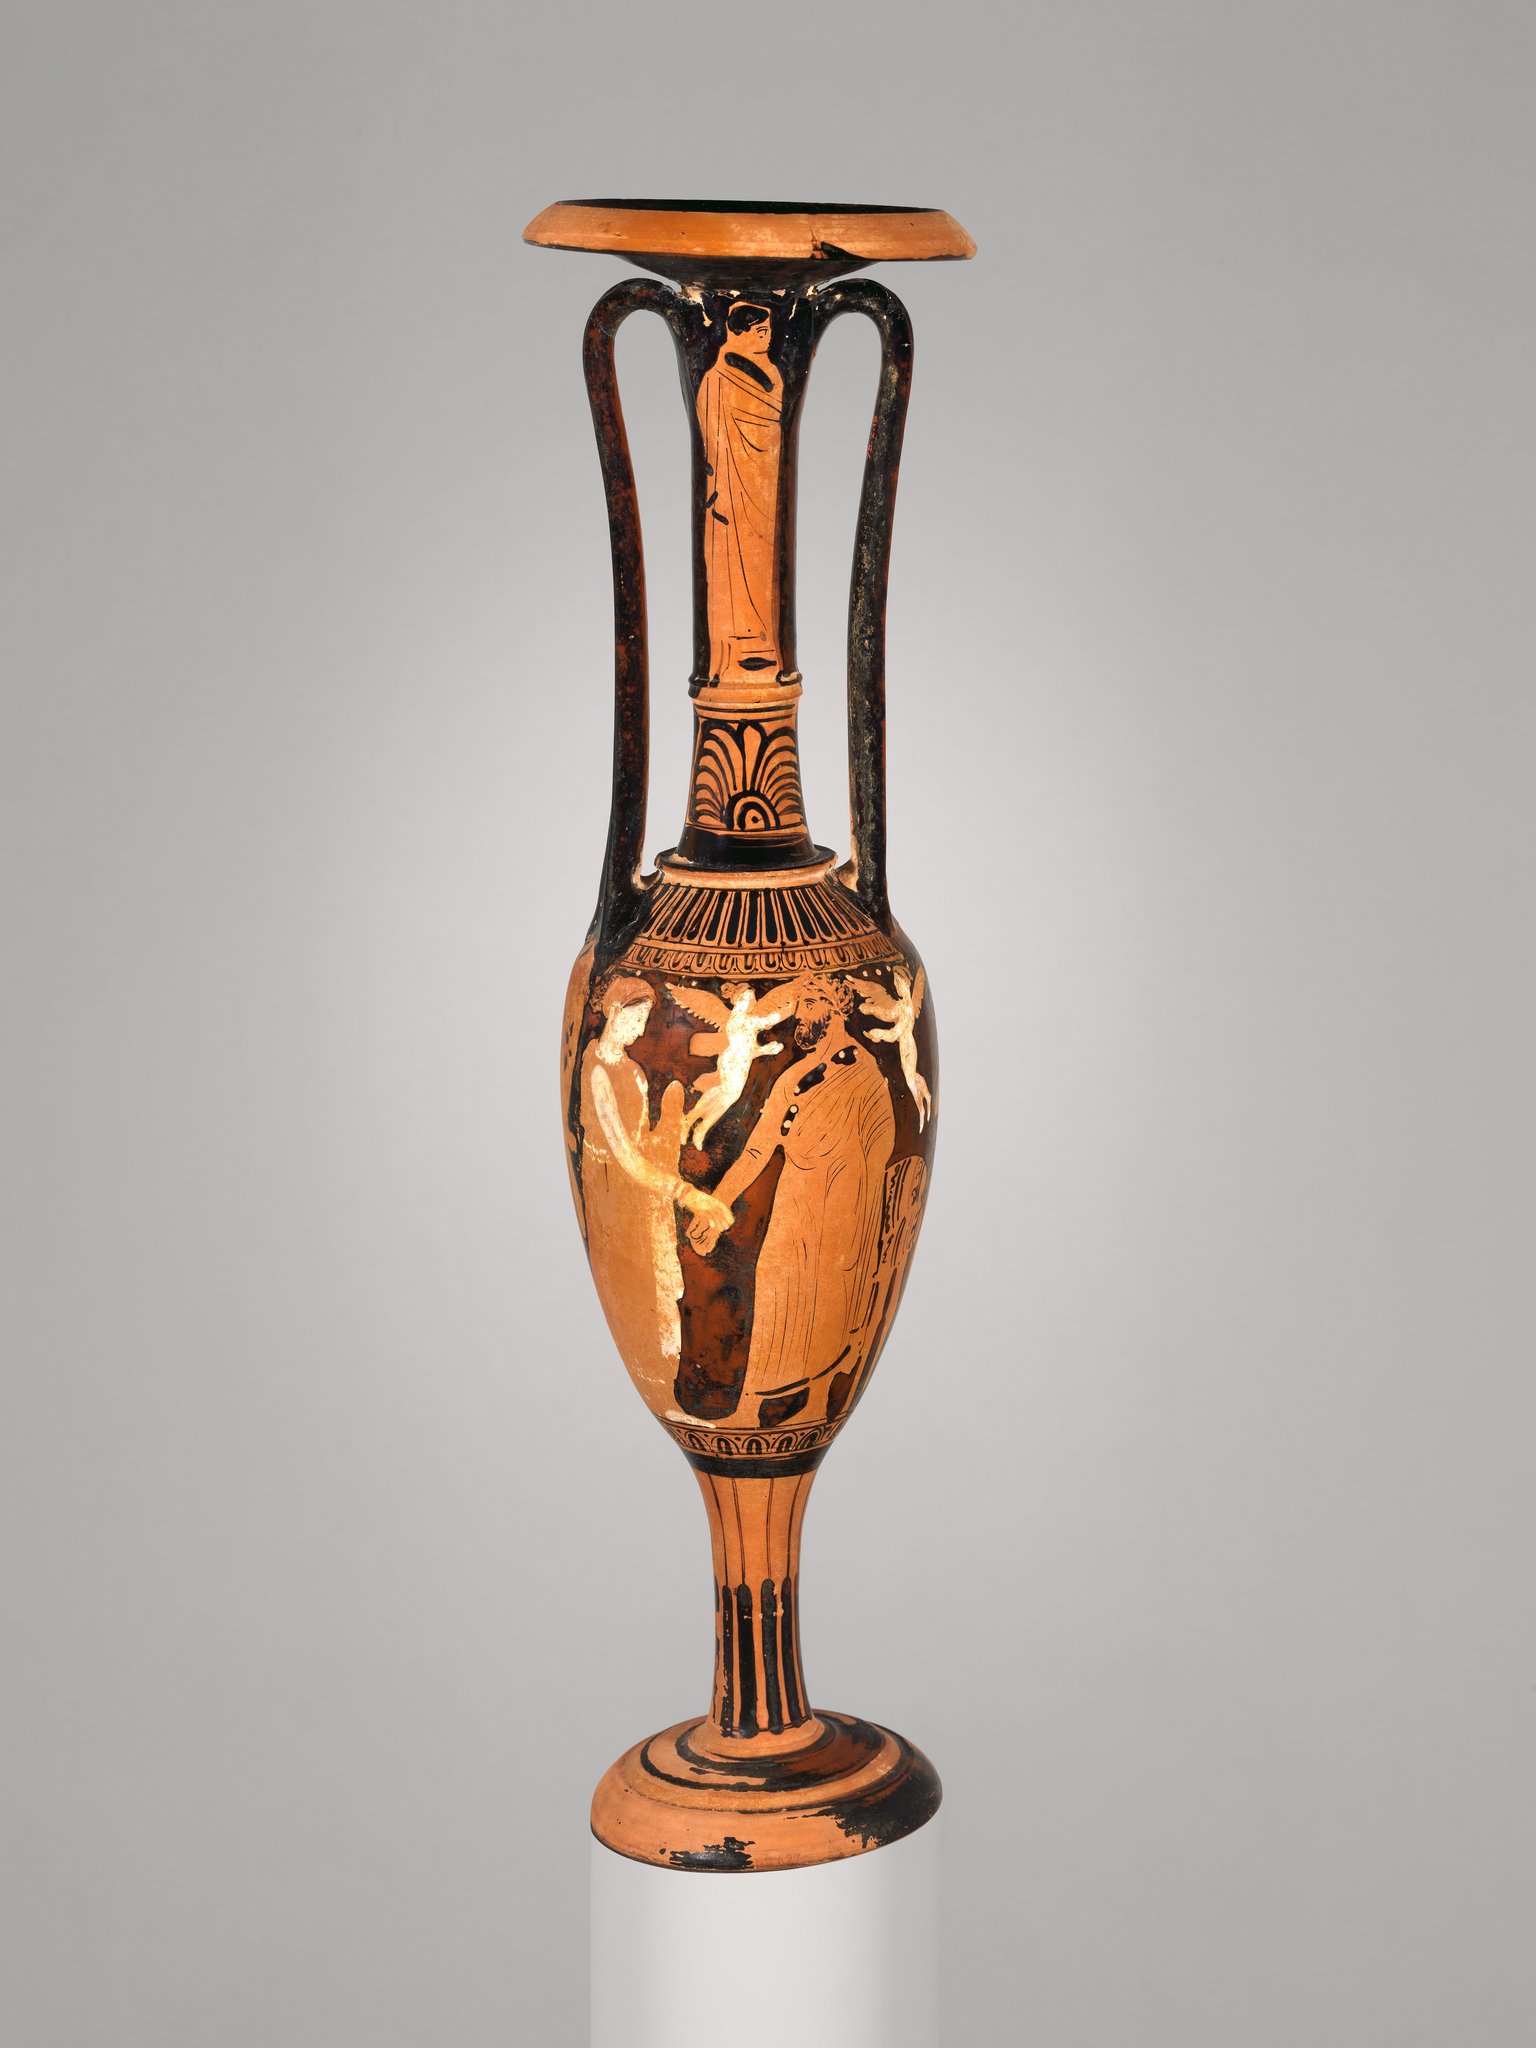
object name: loutrophoros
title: Terracotta loutrophoros (ceremonial vase for water)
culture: greek, attic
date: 400 BCE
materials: terracotta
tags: men,women,eros,weddings